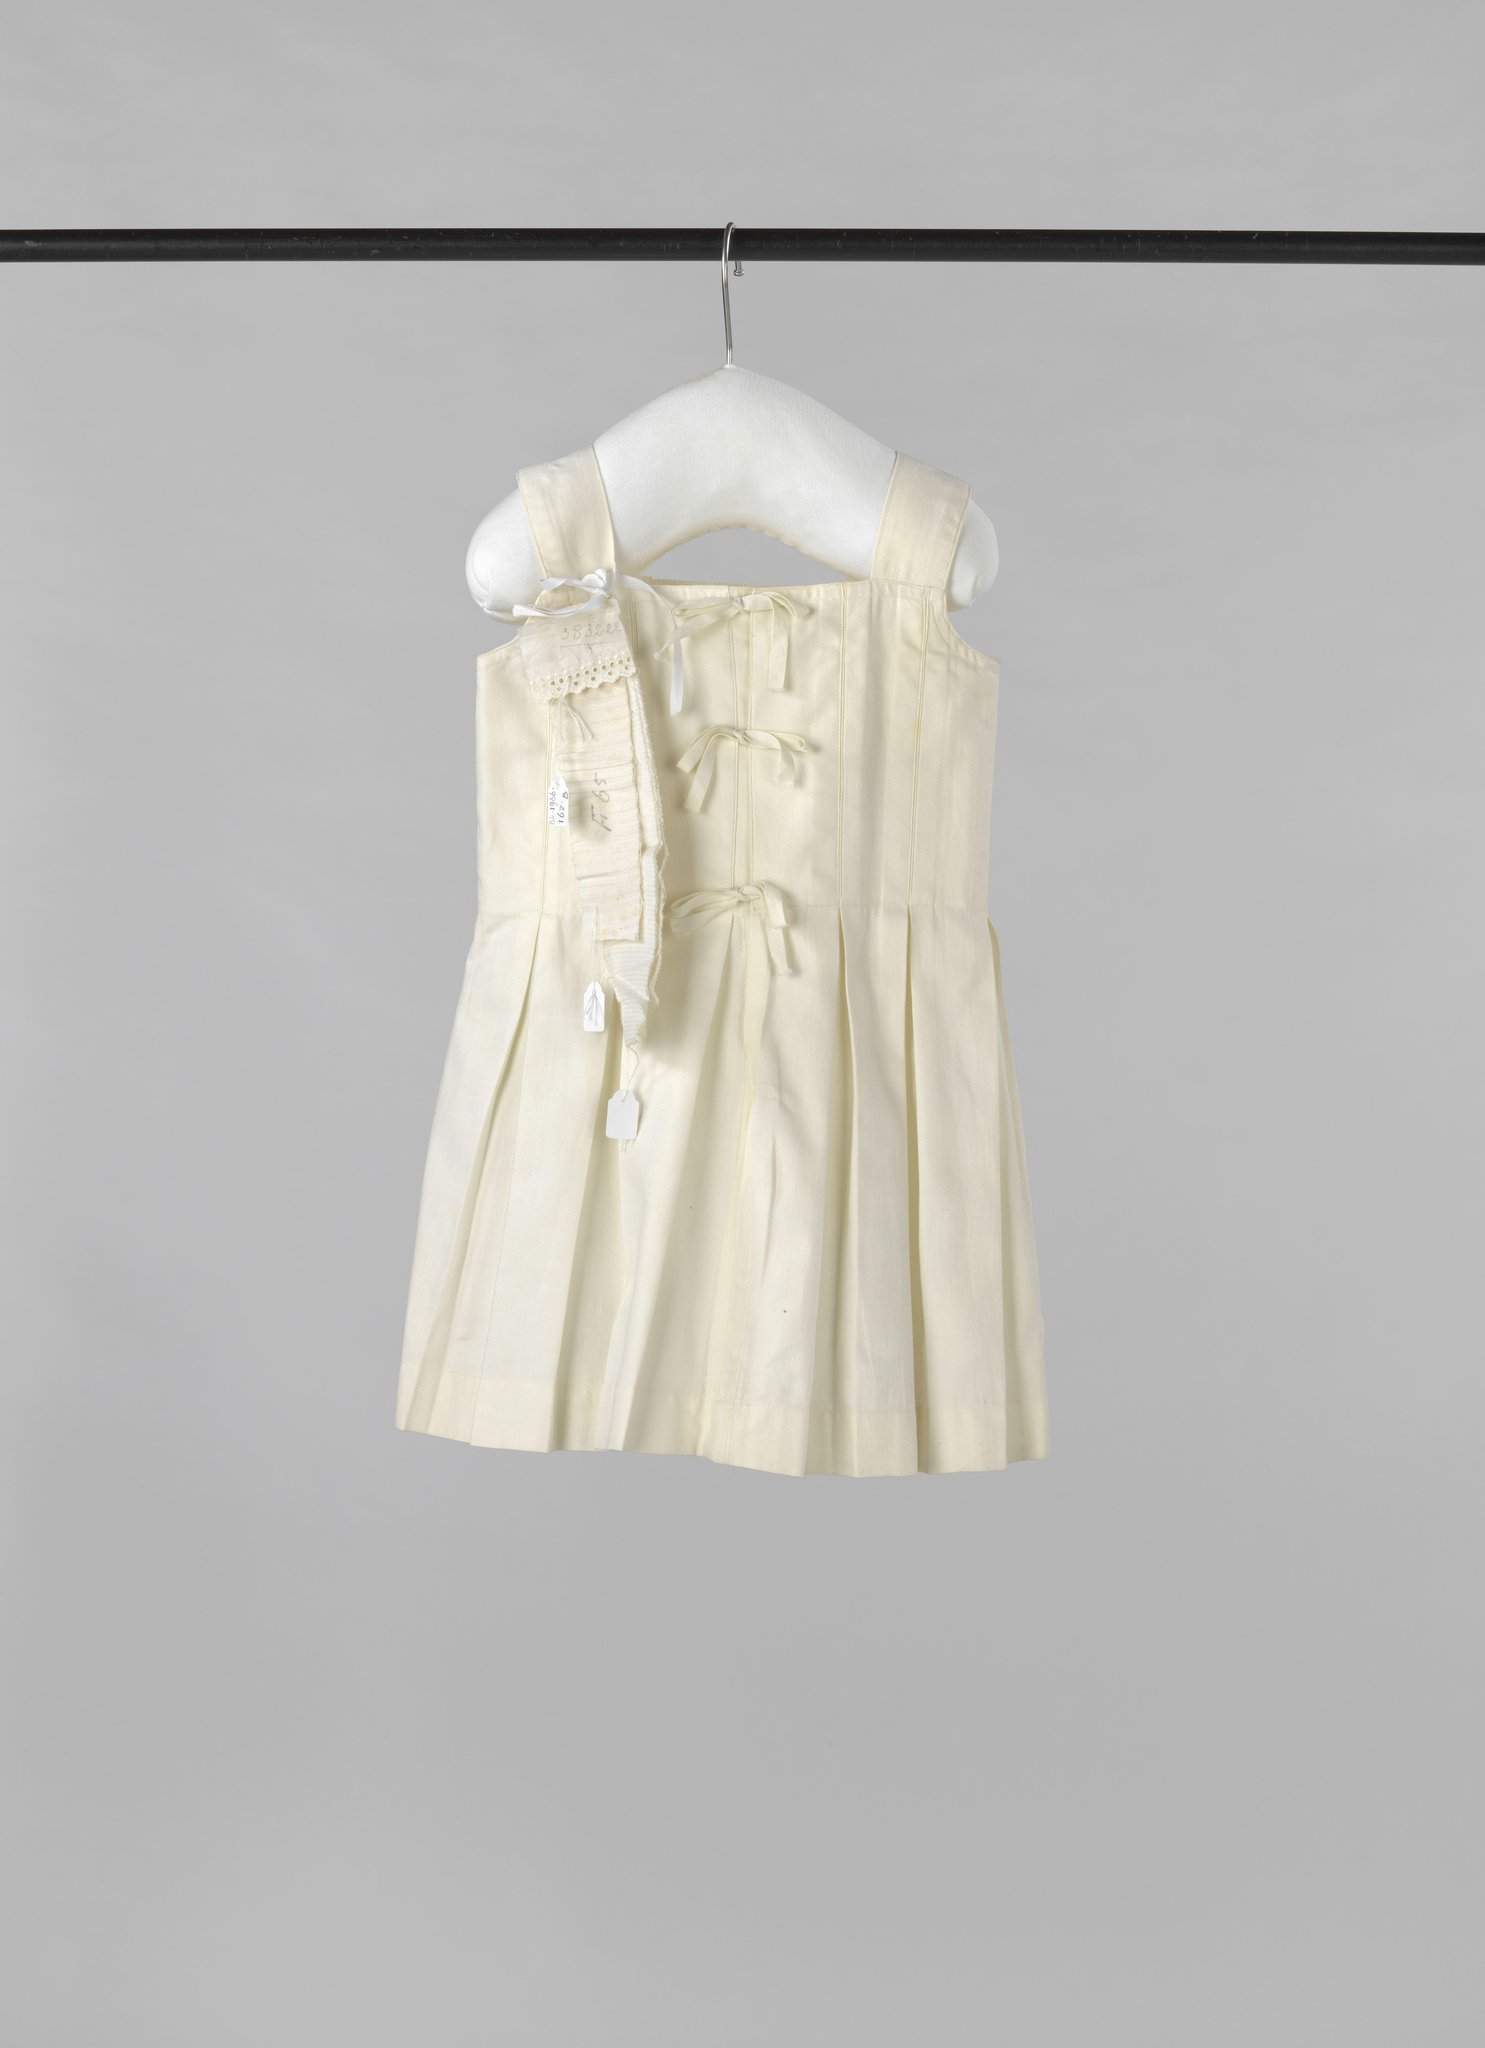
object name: fragment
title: Fragment of staal witte katoenen keper met streepdessin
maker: Anonymous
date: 1910-1930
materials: cotton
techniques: weave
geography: netherlands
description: Fragment of staal witte katoenen keper met streepdessin. Genummerd in potlood: "F165".